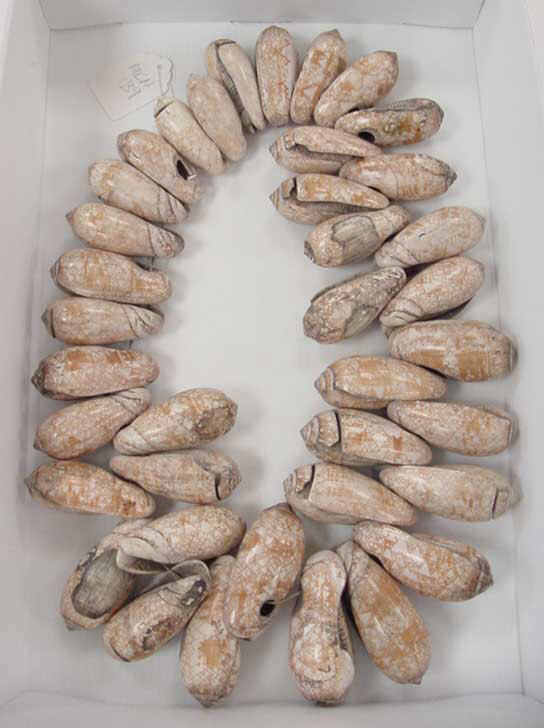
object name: necklace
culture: oceanic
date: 1801-1900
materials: cotton, metal, shell